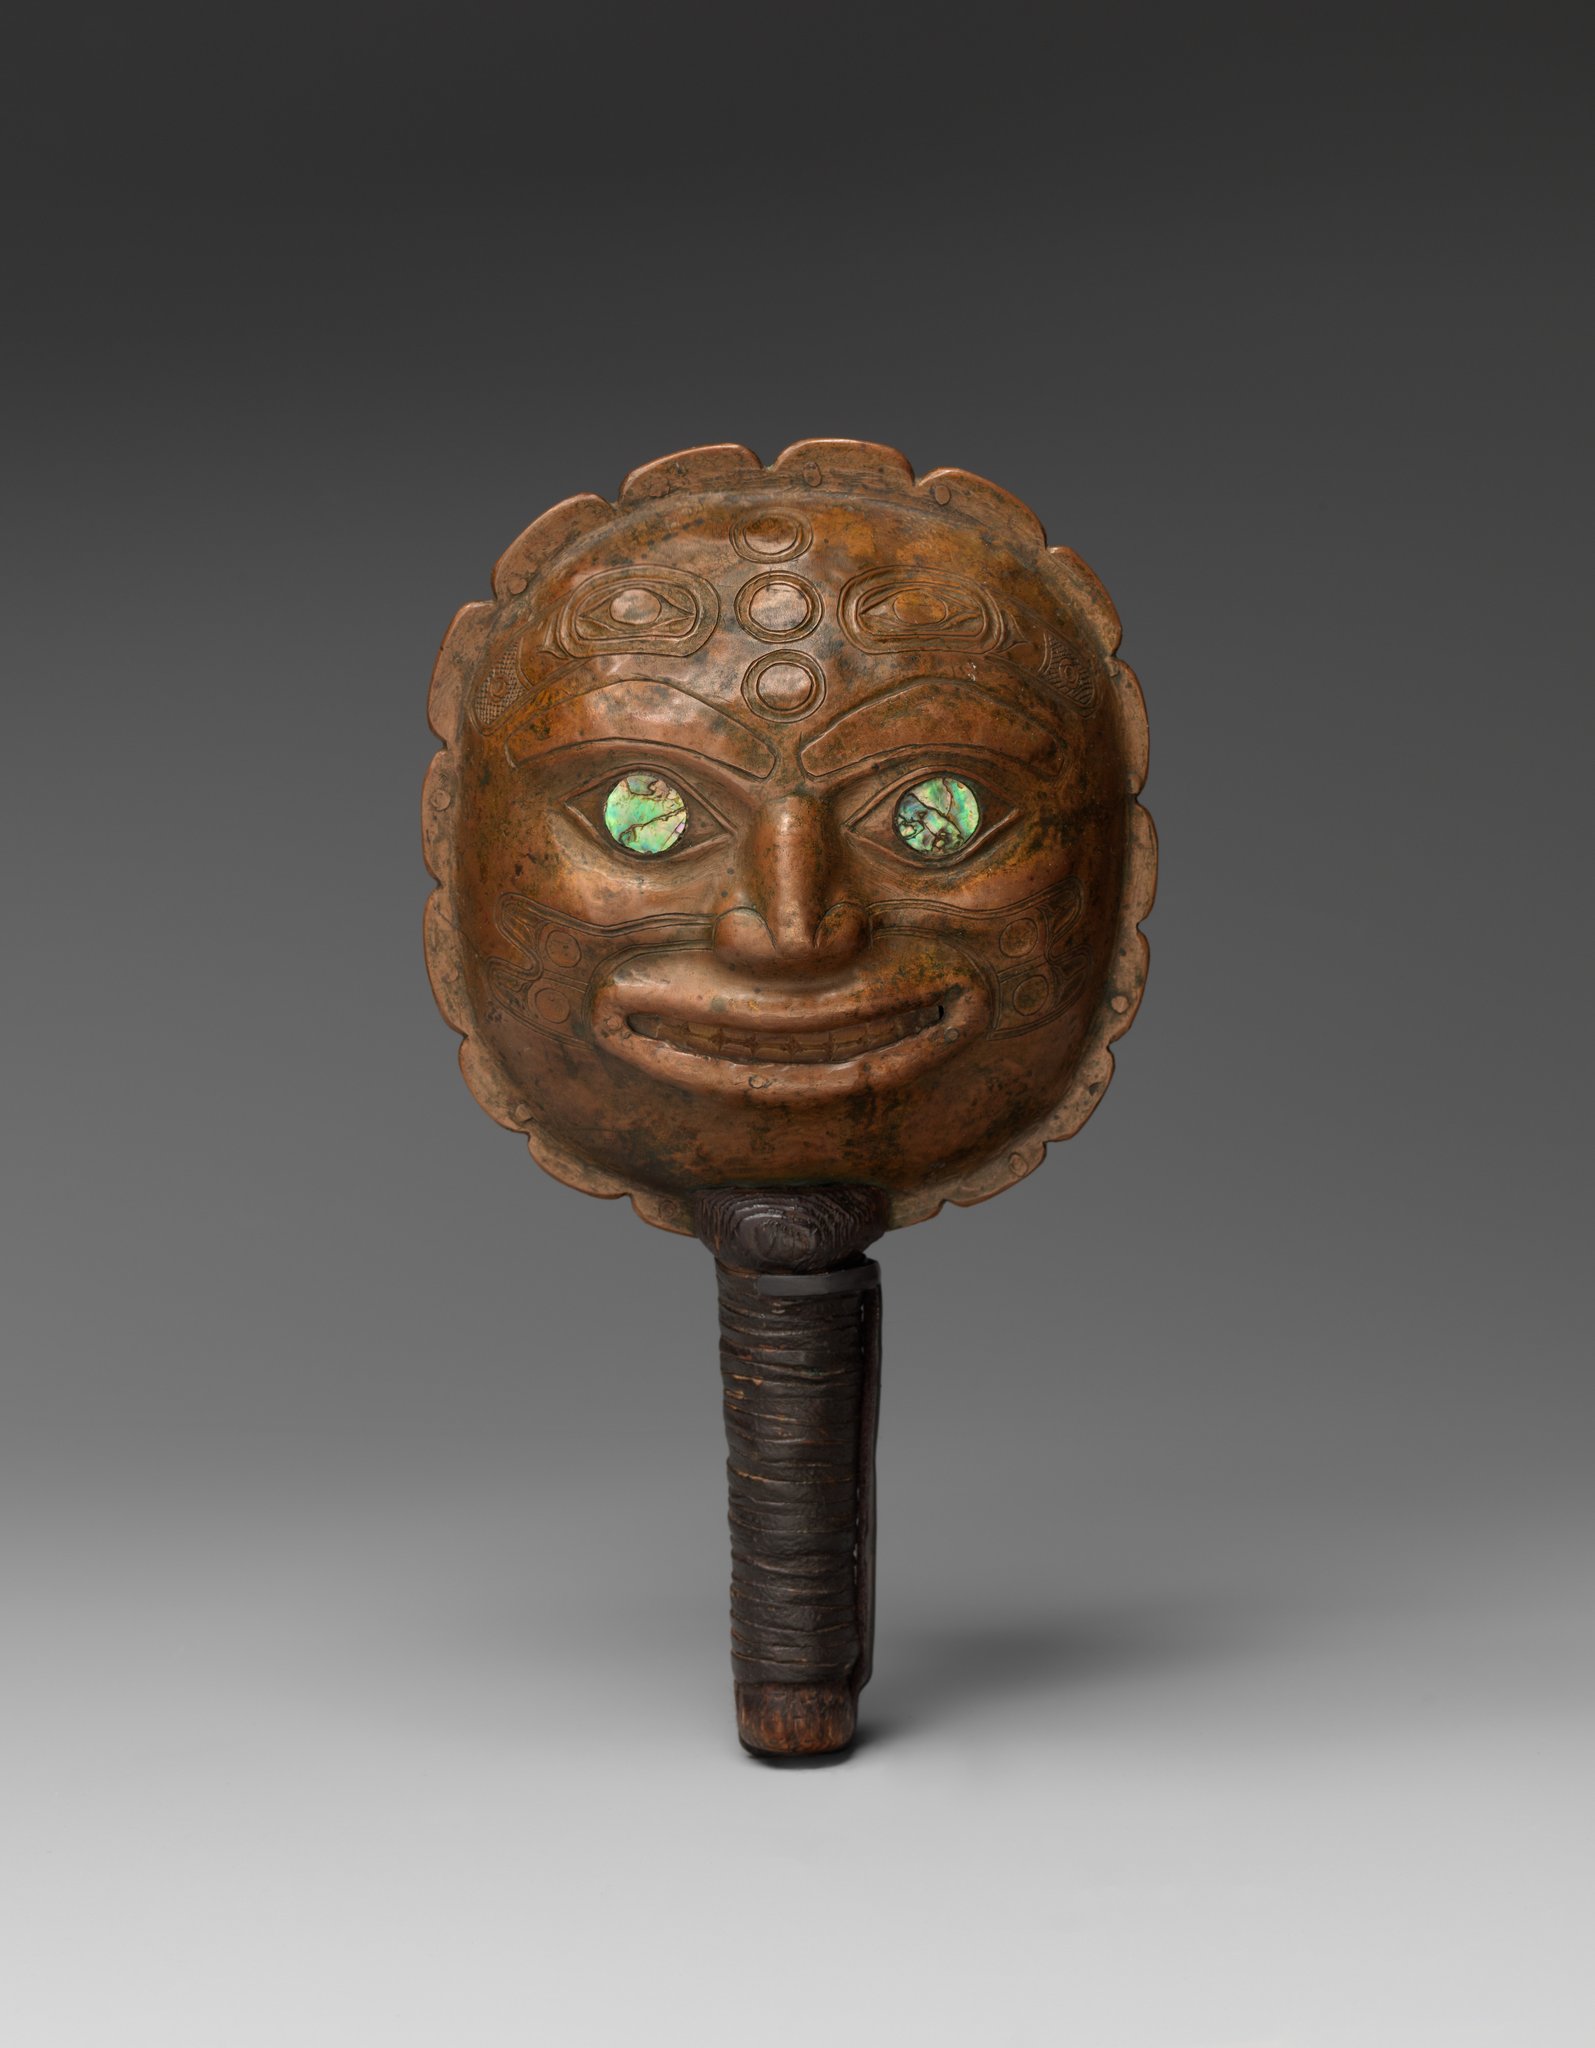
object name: rattle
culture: tlingit or native american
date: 1890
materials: copper, horn, leather, shell, wood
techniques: tanning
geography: united states